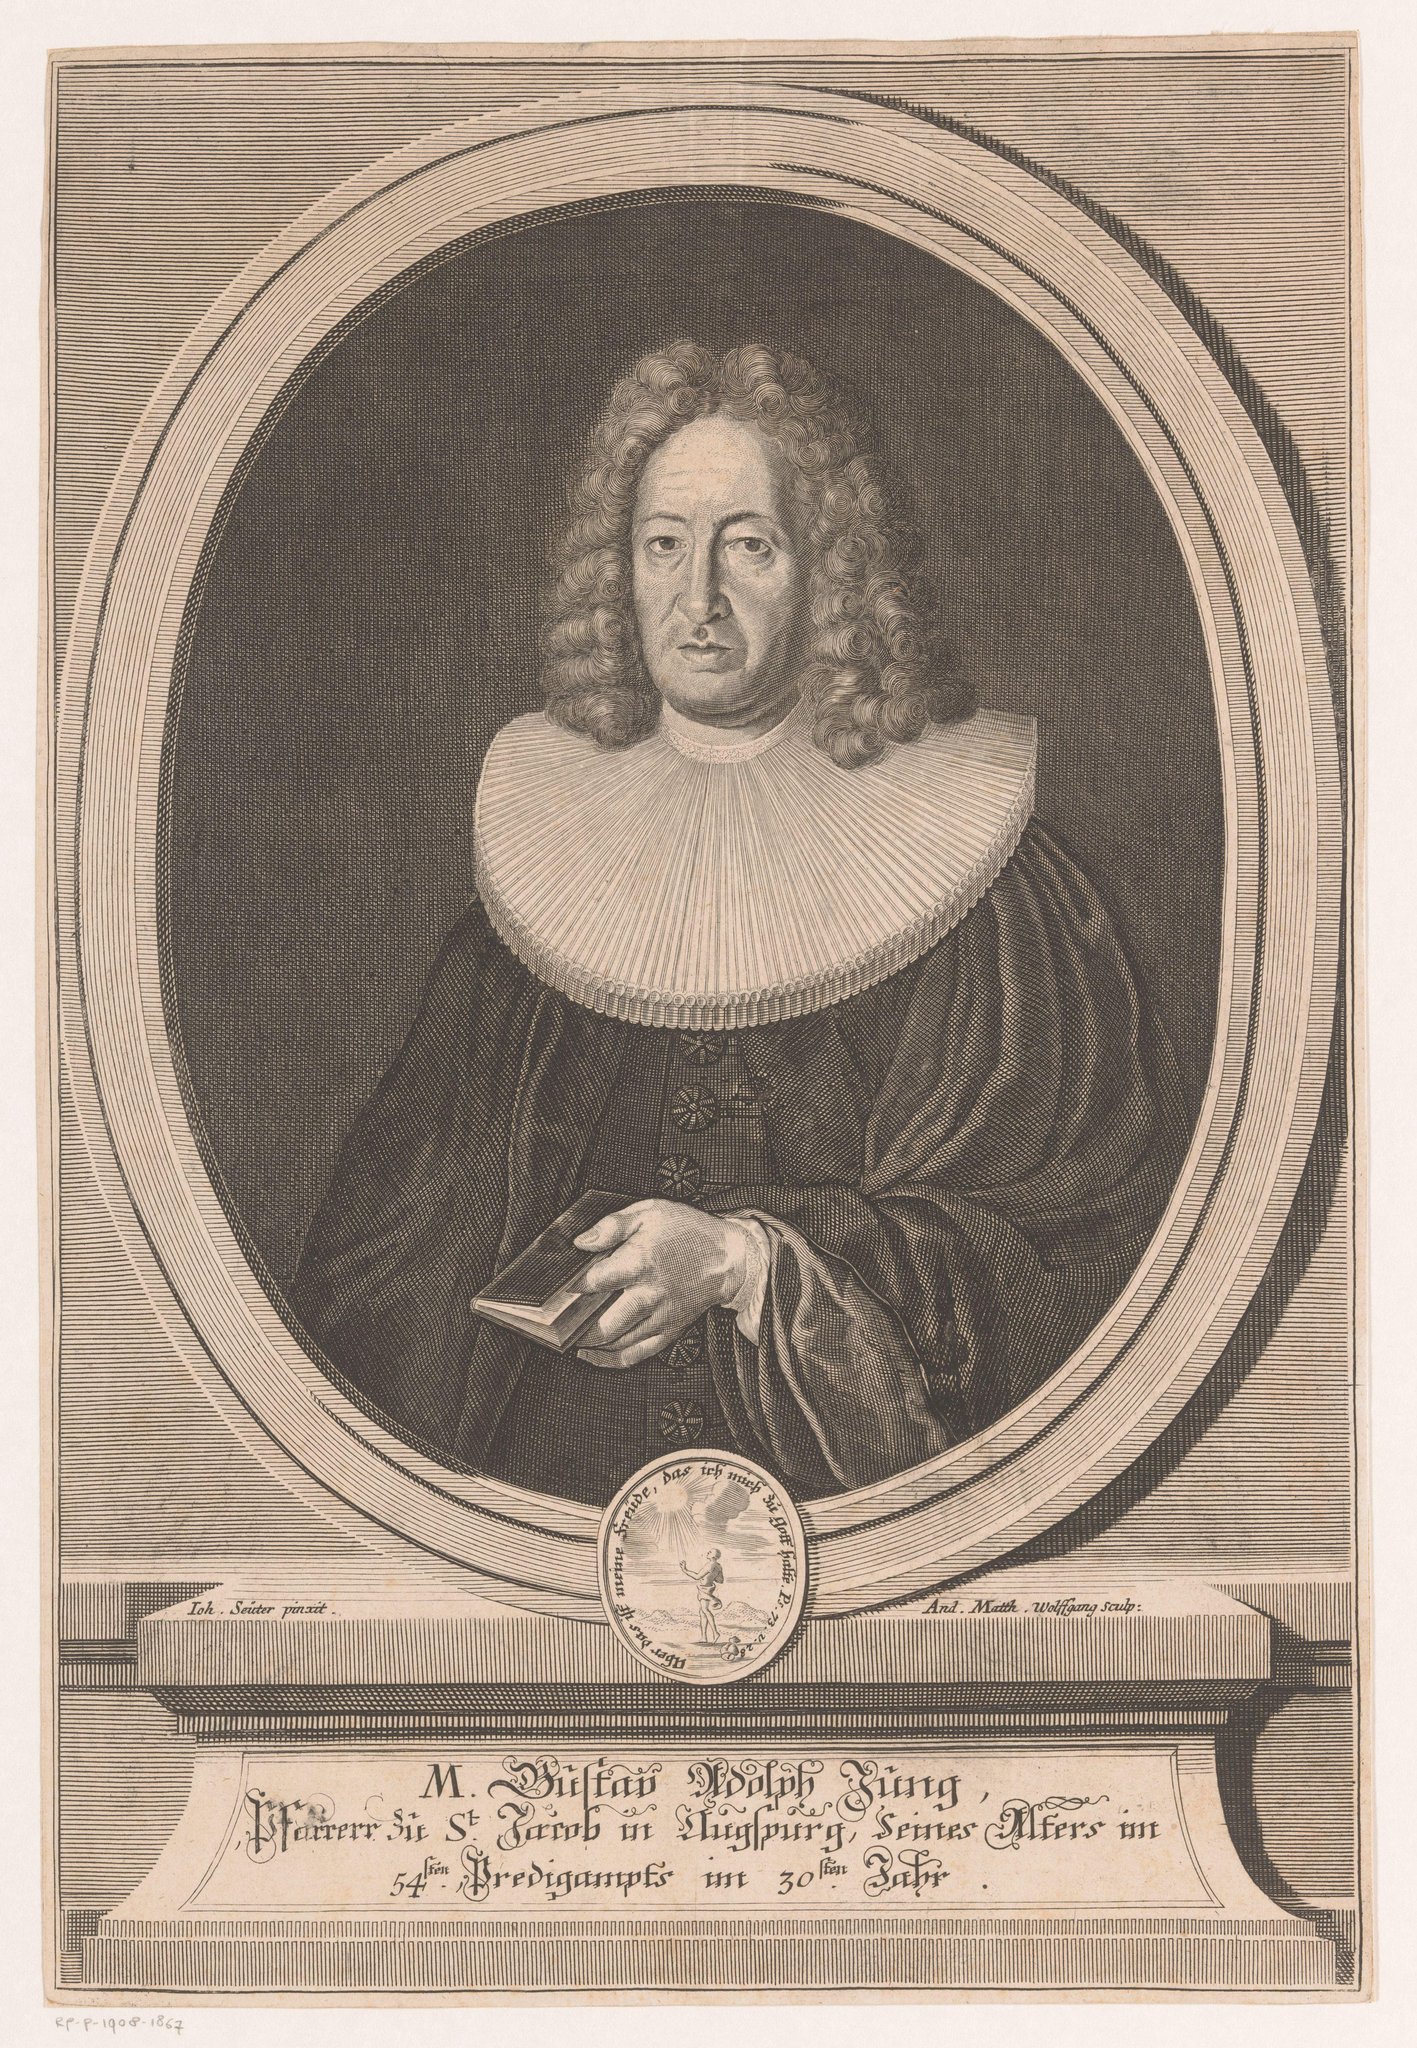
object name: print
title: Portret van Gustav Adolph Jung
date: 1700-1737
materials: paper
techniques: engraving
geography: germany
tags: augsburg, historical persons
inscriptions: collector's mark: Lugt 2228, collector's mark: Lugt 9